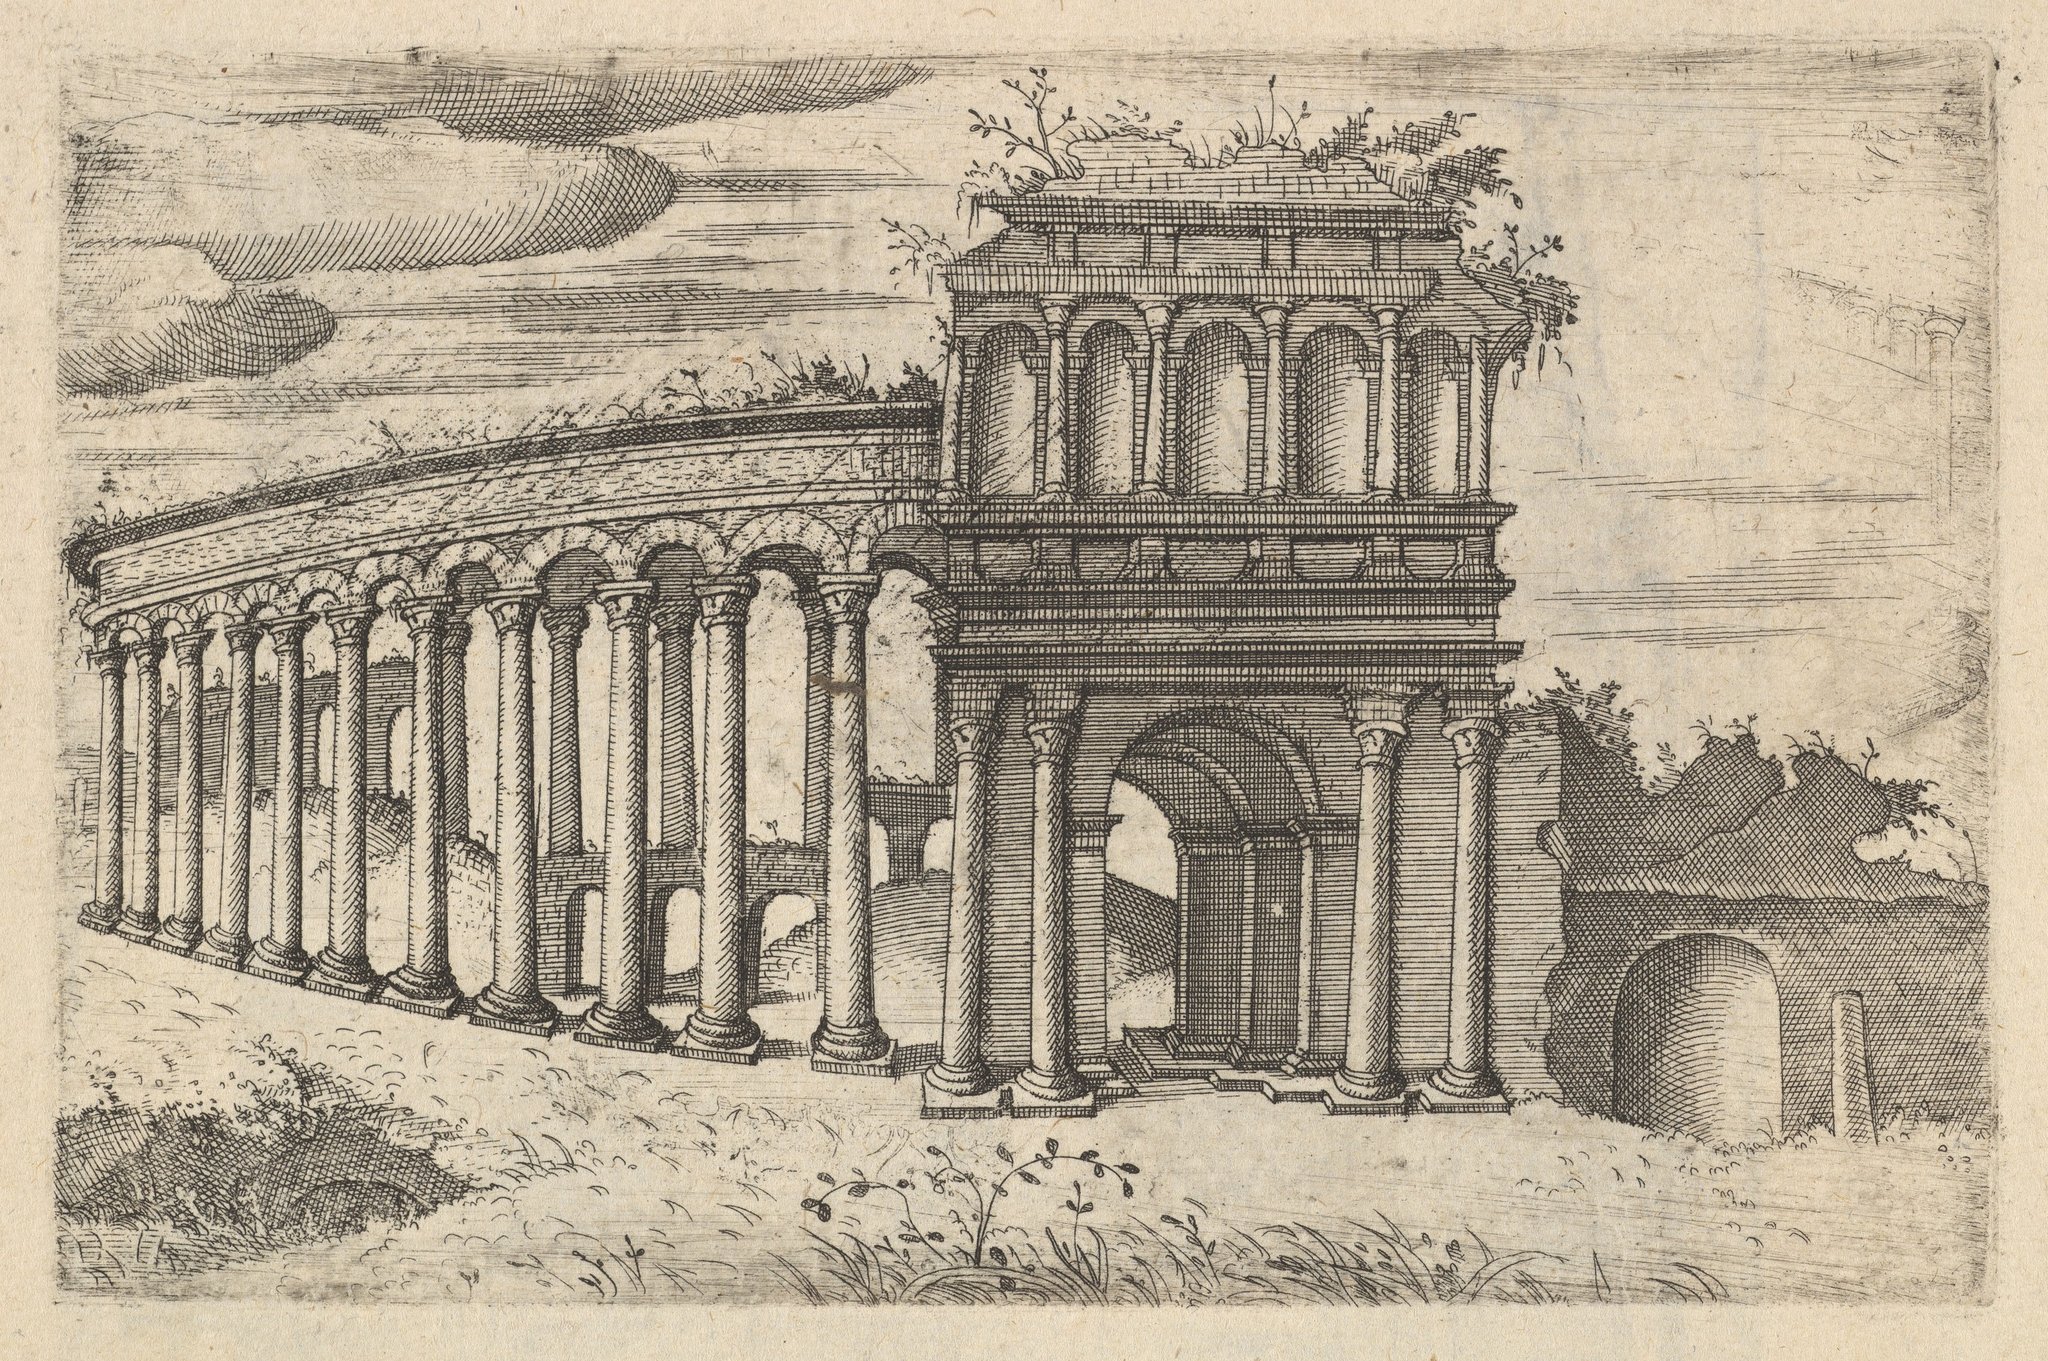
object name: book print ornament architecture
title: The Amphitheater in Bordeaux [Teatrum Bordeos; Transitorium Caesaris], from the series 'Ruinarum variarum fabricarum delineationes pictoribus caeterisque id genus artificibus multum utiles'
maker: lambert suavius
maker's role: artist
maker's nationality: netherlandish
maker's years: 1510-1576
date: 1554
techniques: etching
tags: architecture,columns,ruins